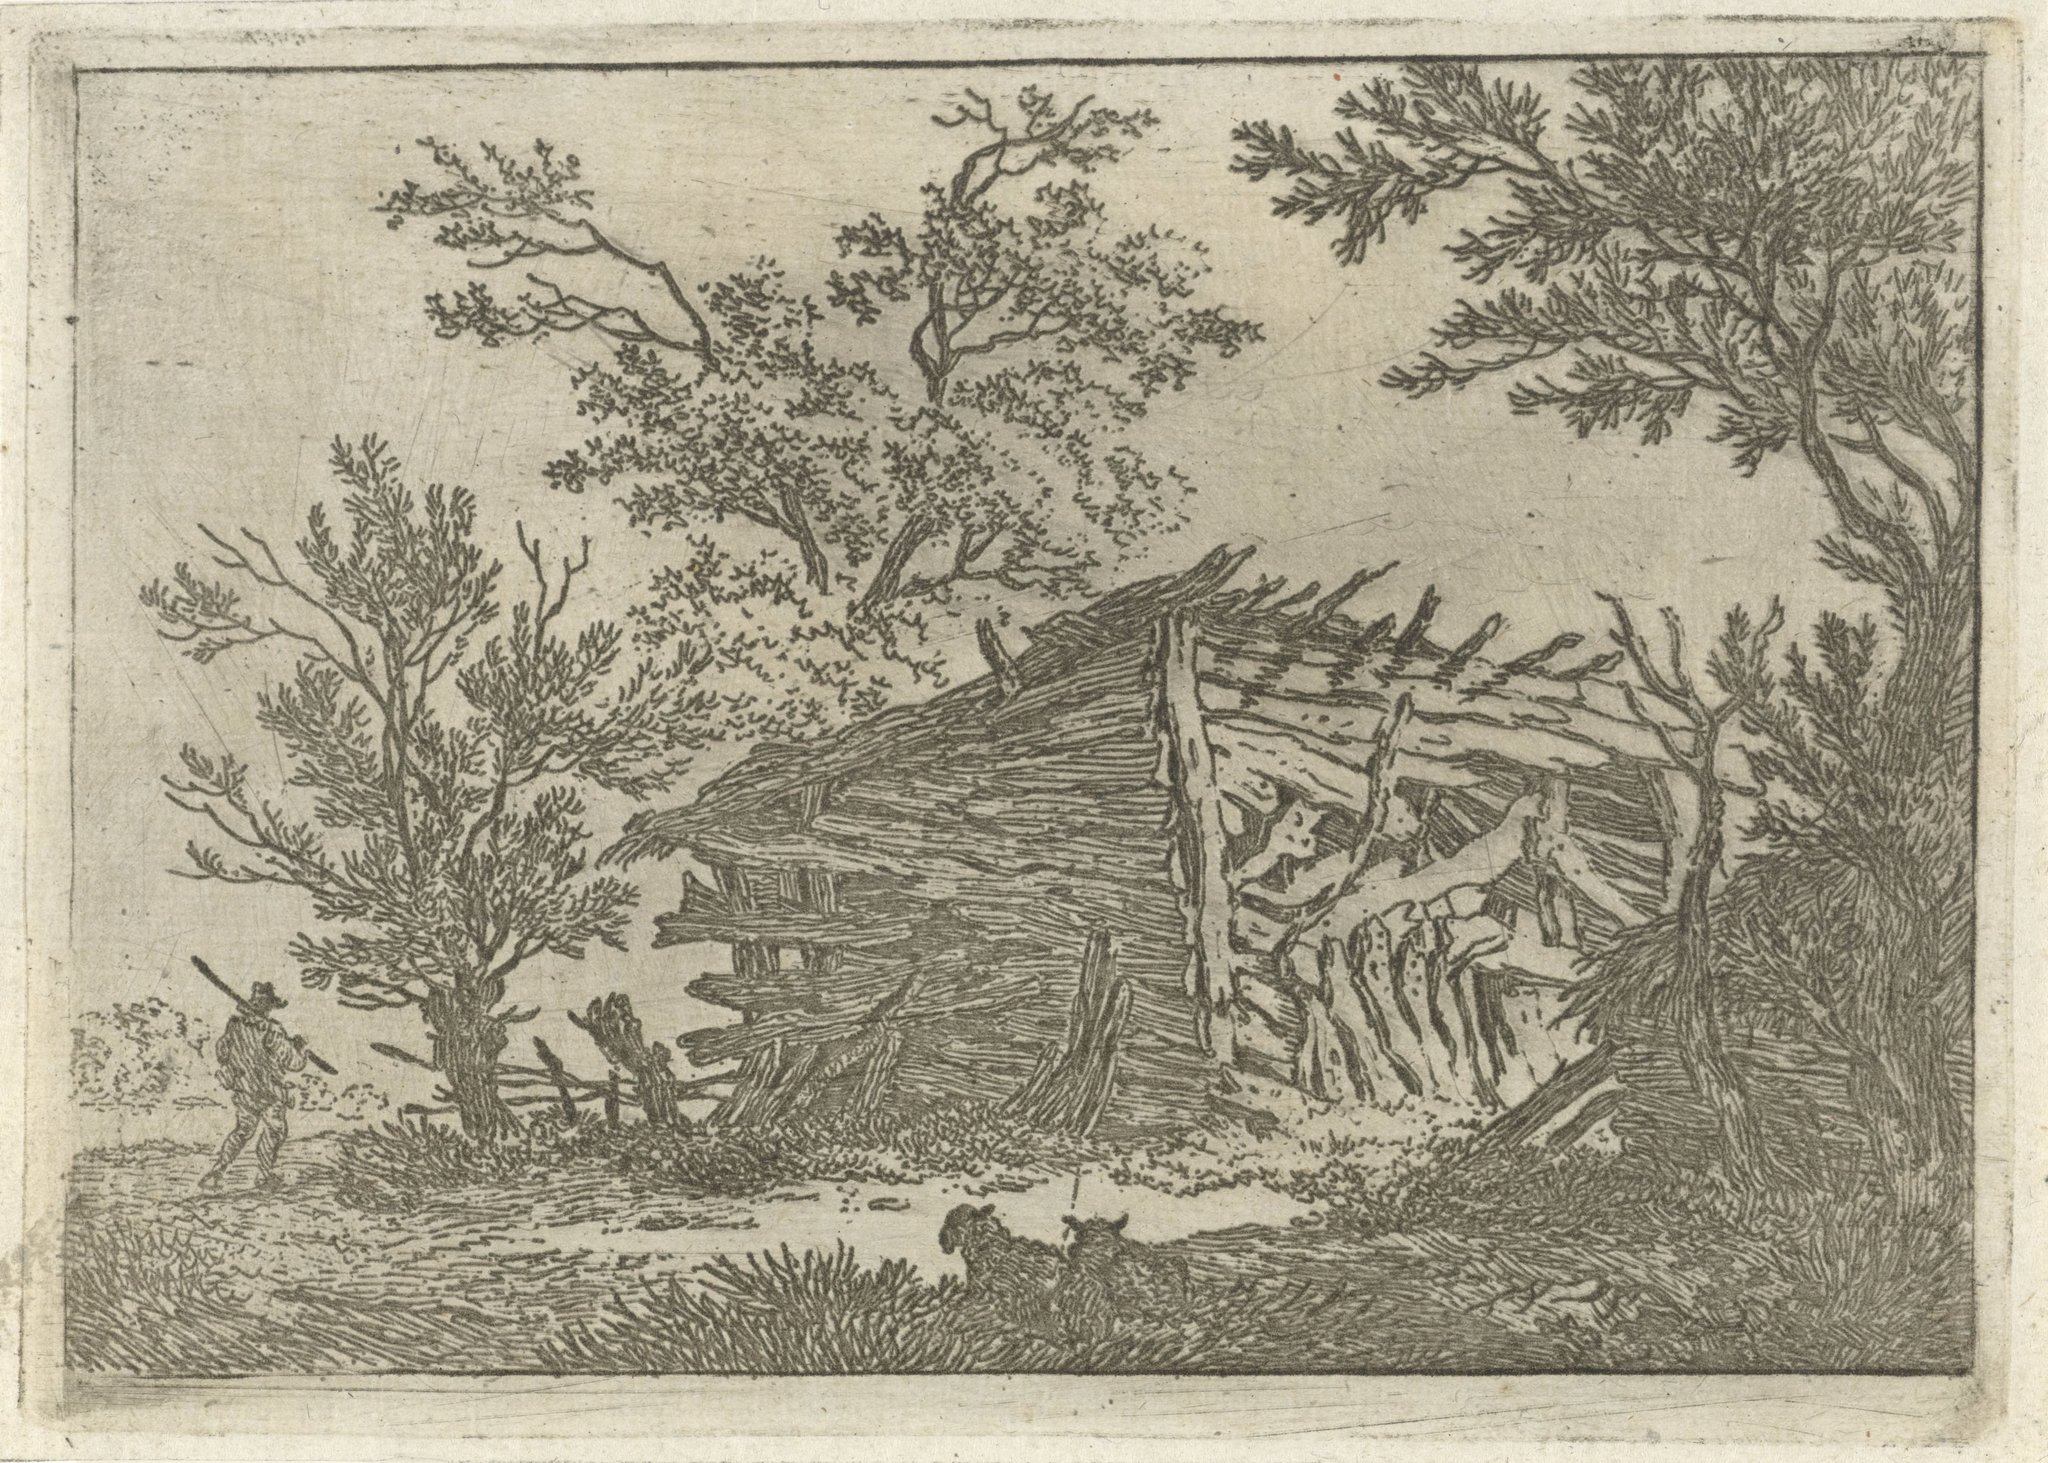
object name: print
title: Landschap met een vervallen boerenschuur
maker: françois joseph pfeiffer (ii)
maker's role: draughtsman, print maker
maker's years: 1778-1835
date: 1793-1835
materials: paper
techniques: etching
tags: sheep, shed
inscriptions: collector's mark: Lugt 2228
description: Landschap met een vervallen boerenschuur. Op de voorgrond twee schapen in het gras.